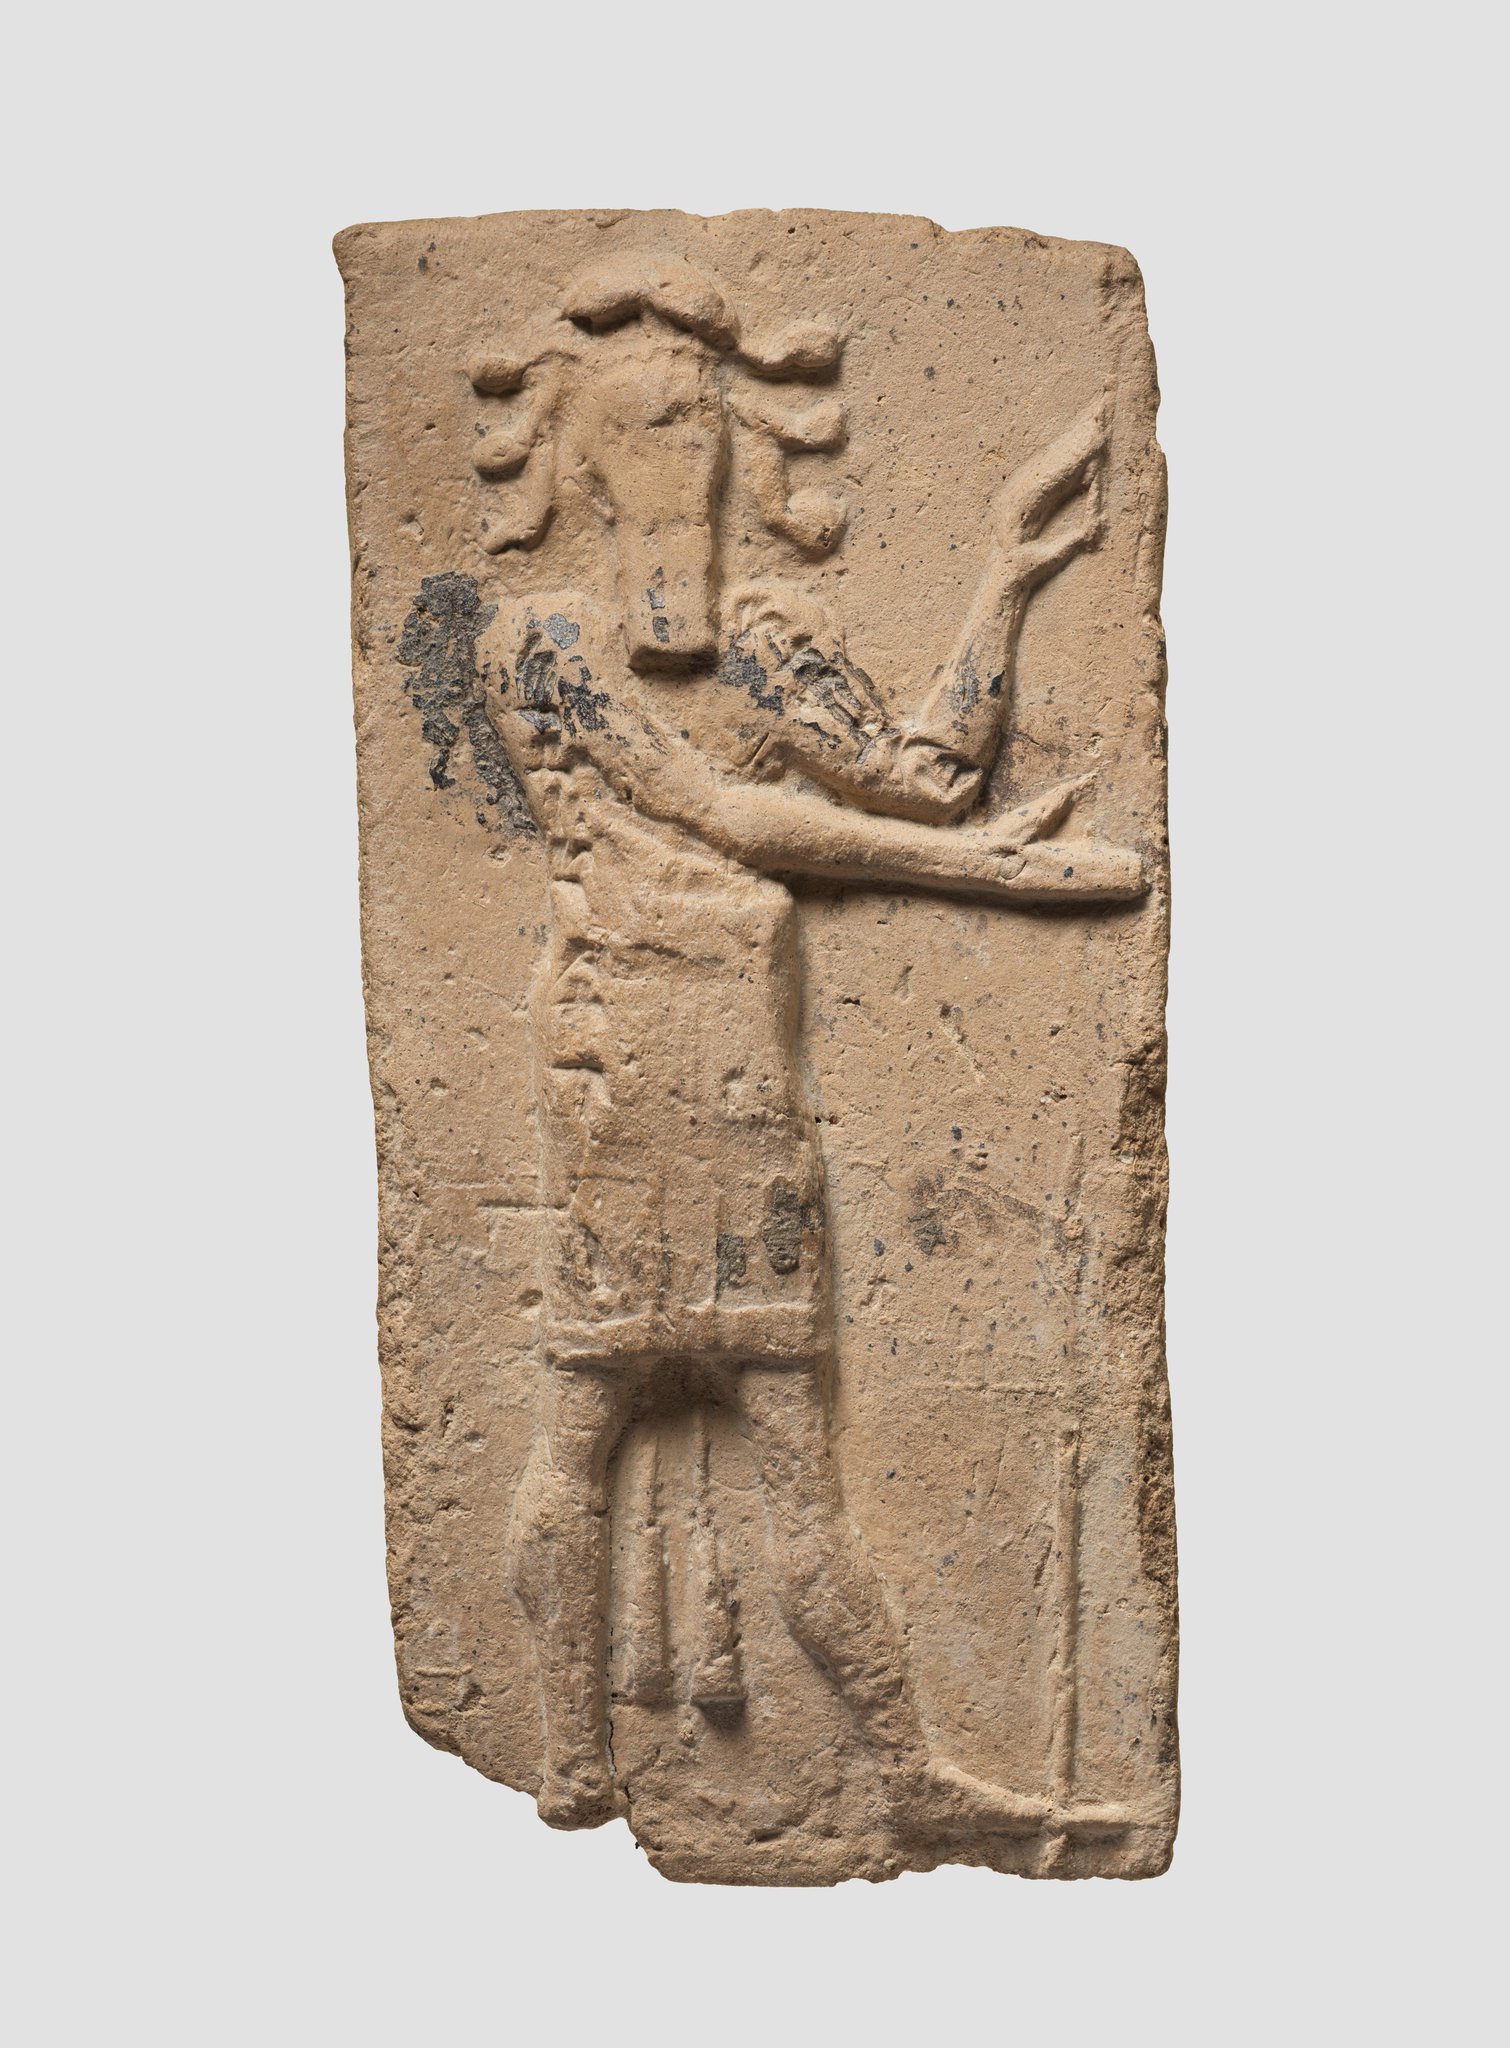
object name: relief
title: Relief plaque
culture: assyrian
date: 734-601 BCE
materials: ceramic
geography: mesopotamia